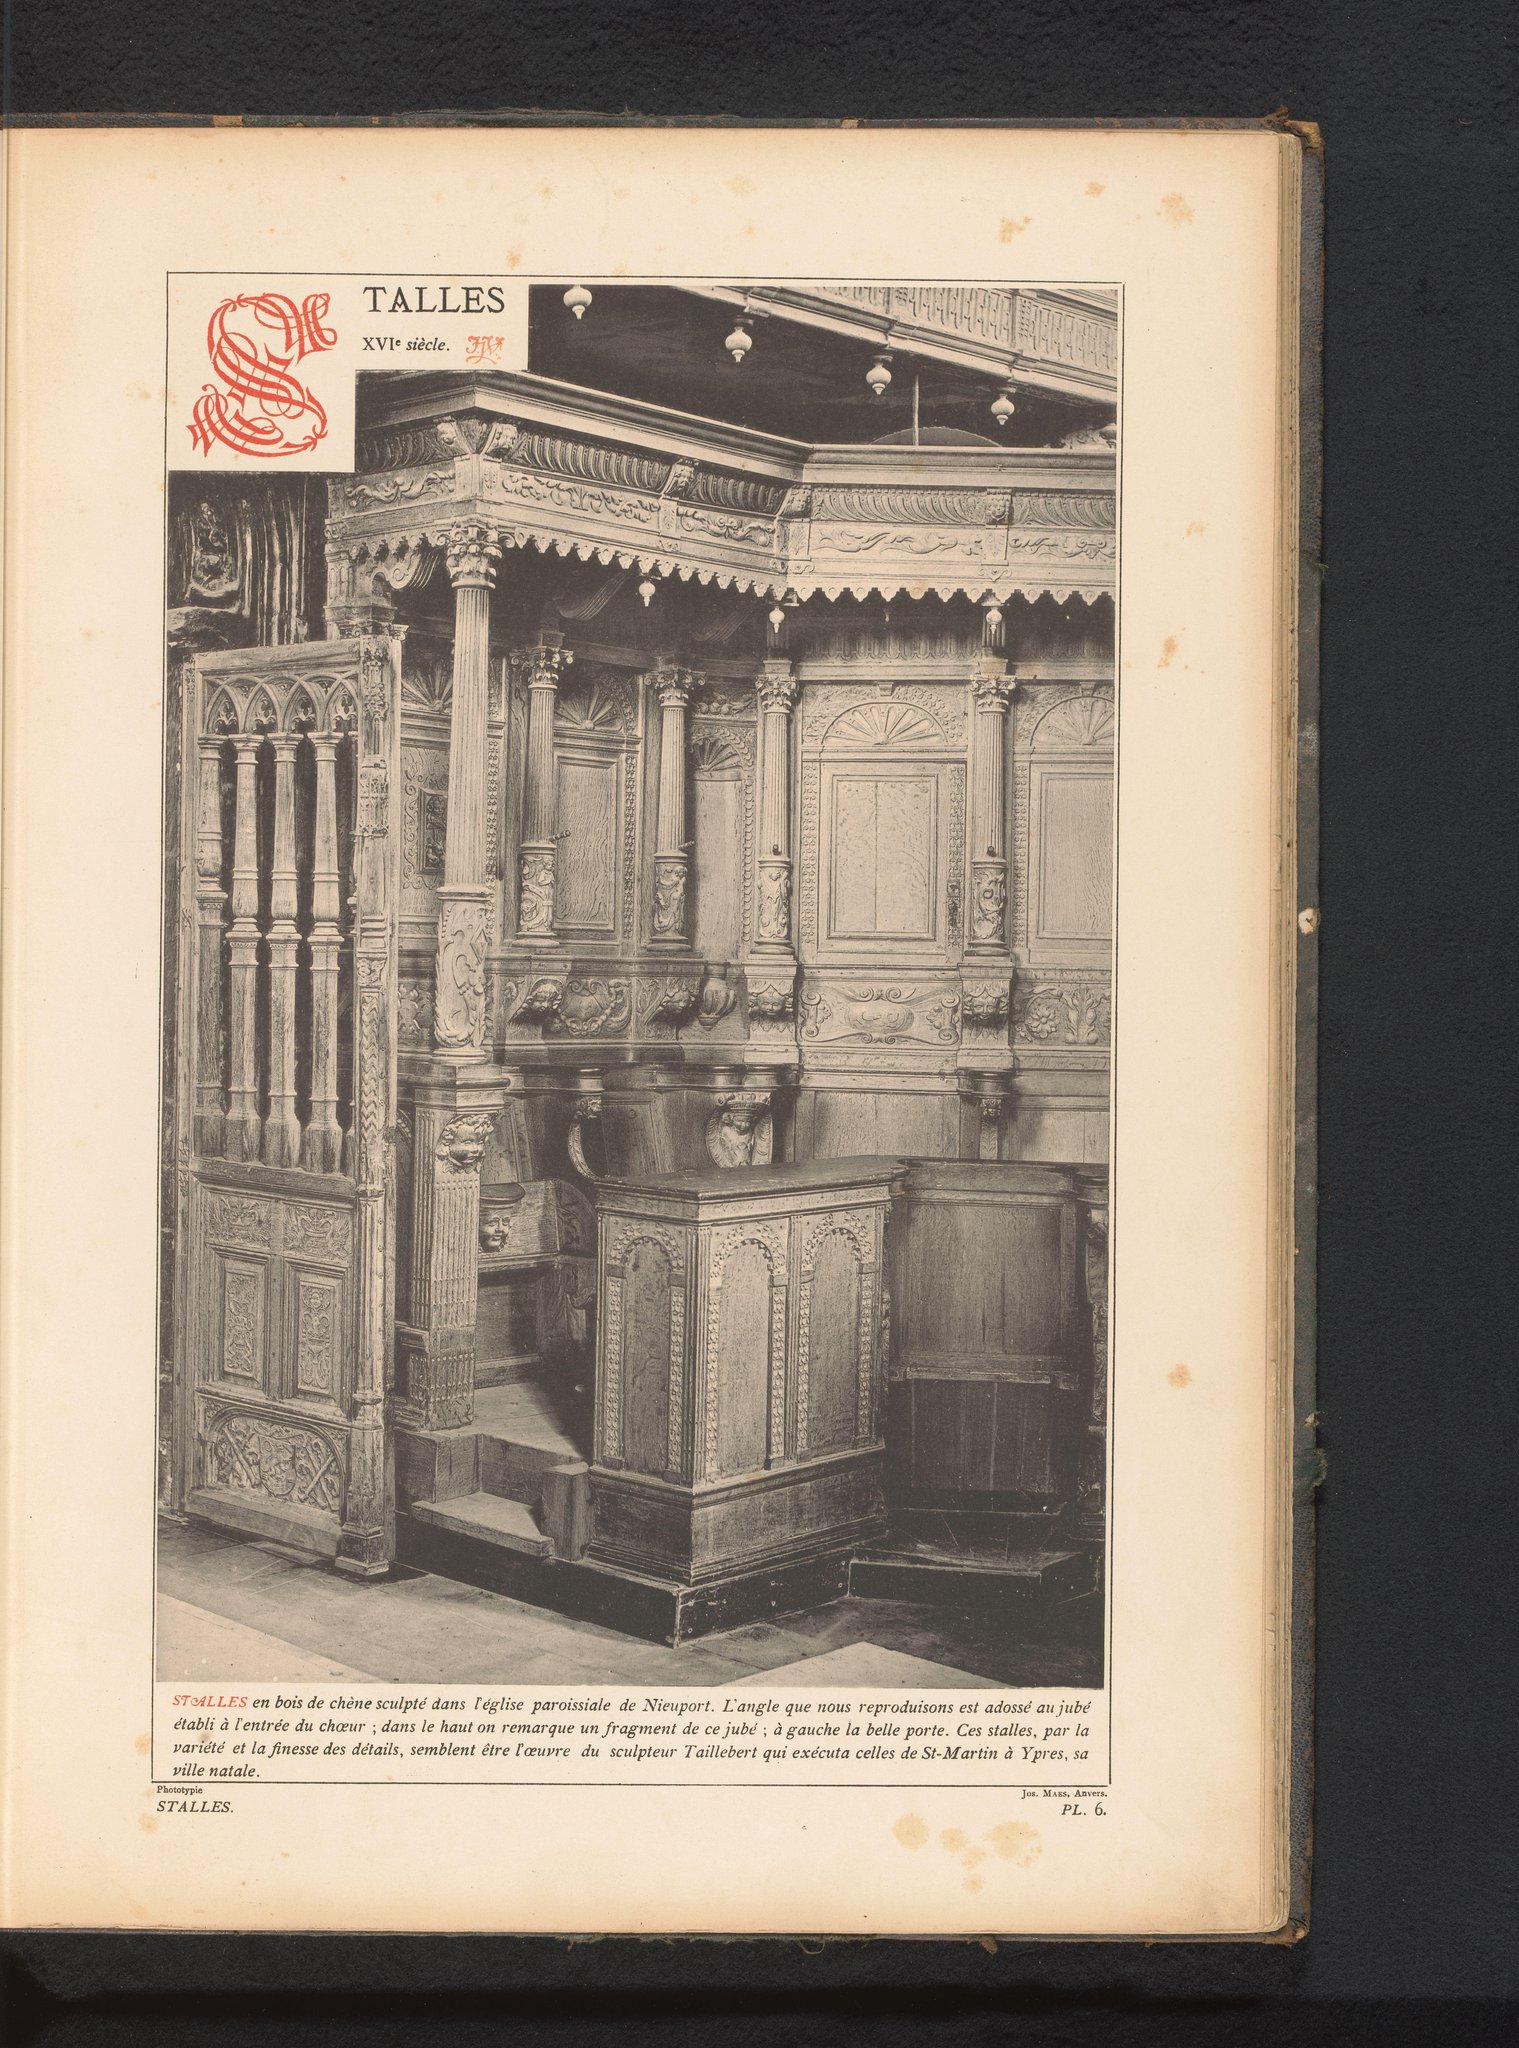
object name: photomechanical print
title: Stalles, XVIe siècle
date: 1882-1887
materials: paper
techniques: photograph, photolithography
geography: antwerp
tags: bench, parts of church interior: choir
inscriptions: monogram: ‘JJvY’, inscription: ‘STALLES en bois (...)’, inscription: ‘STALLES. - PL. 6.’